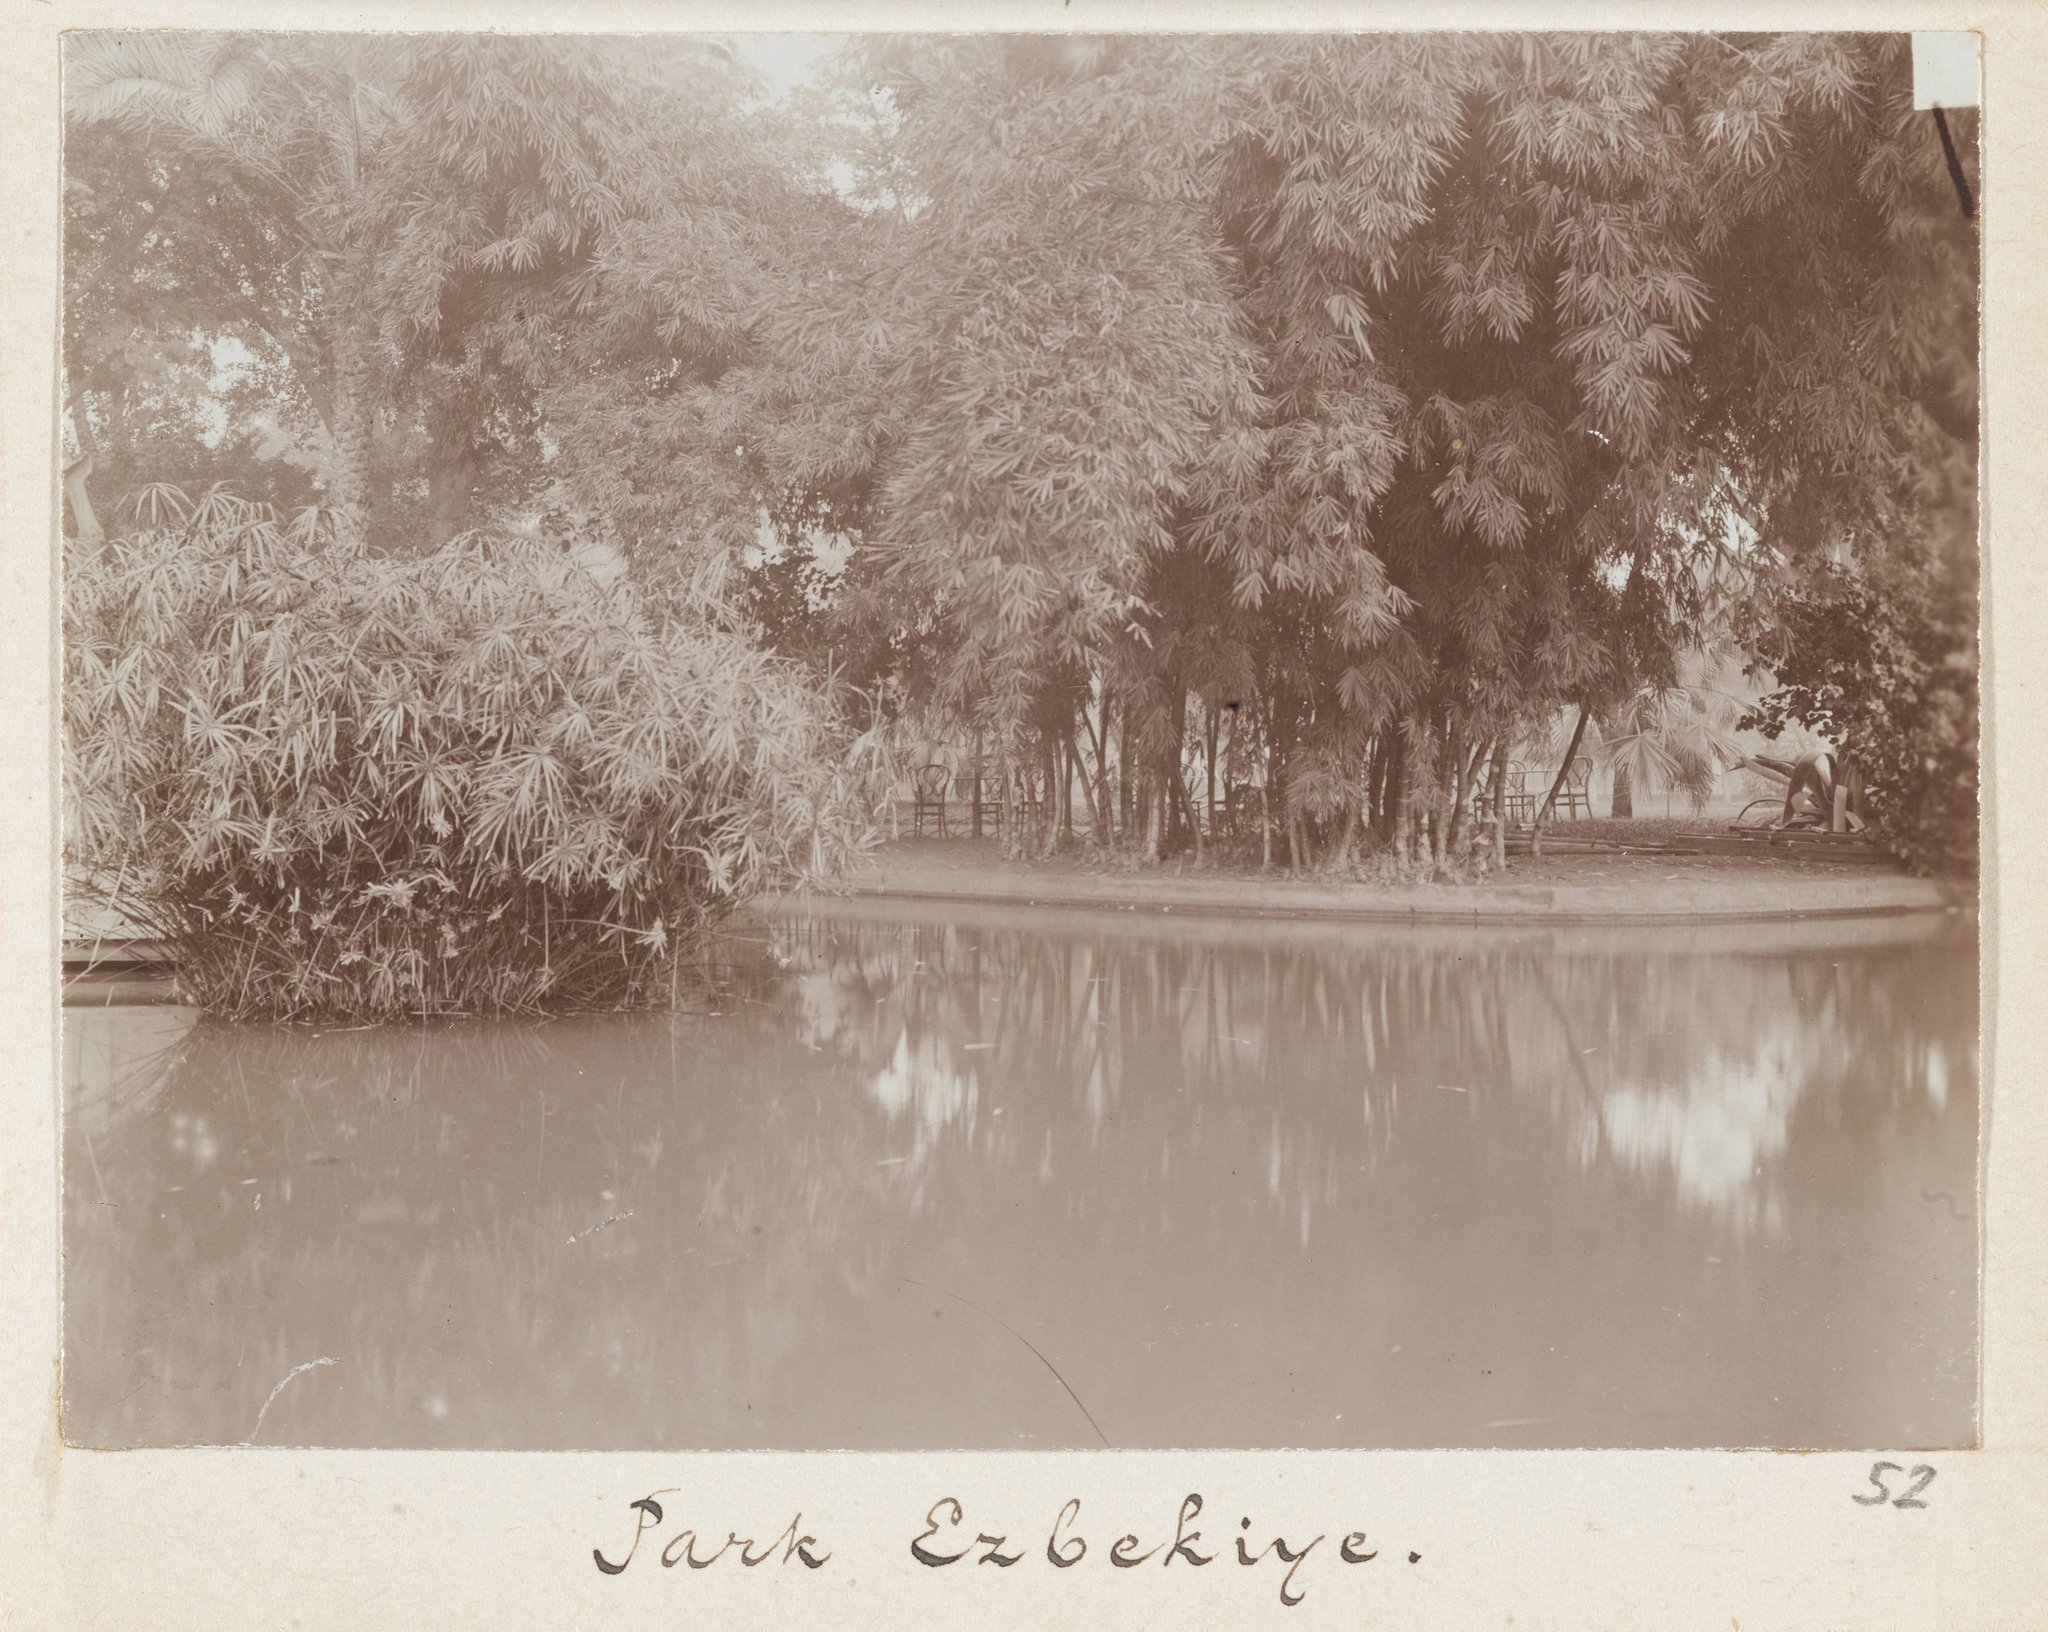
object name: photograph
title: Parkvijver in Azbakeya, Caïro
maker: johannes lodewijk heldring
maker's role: fotograaf, predikant, schrijver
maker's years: 1852-1923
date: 1898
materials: paper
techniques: collodion silver print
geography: cairo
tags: park, garden pond